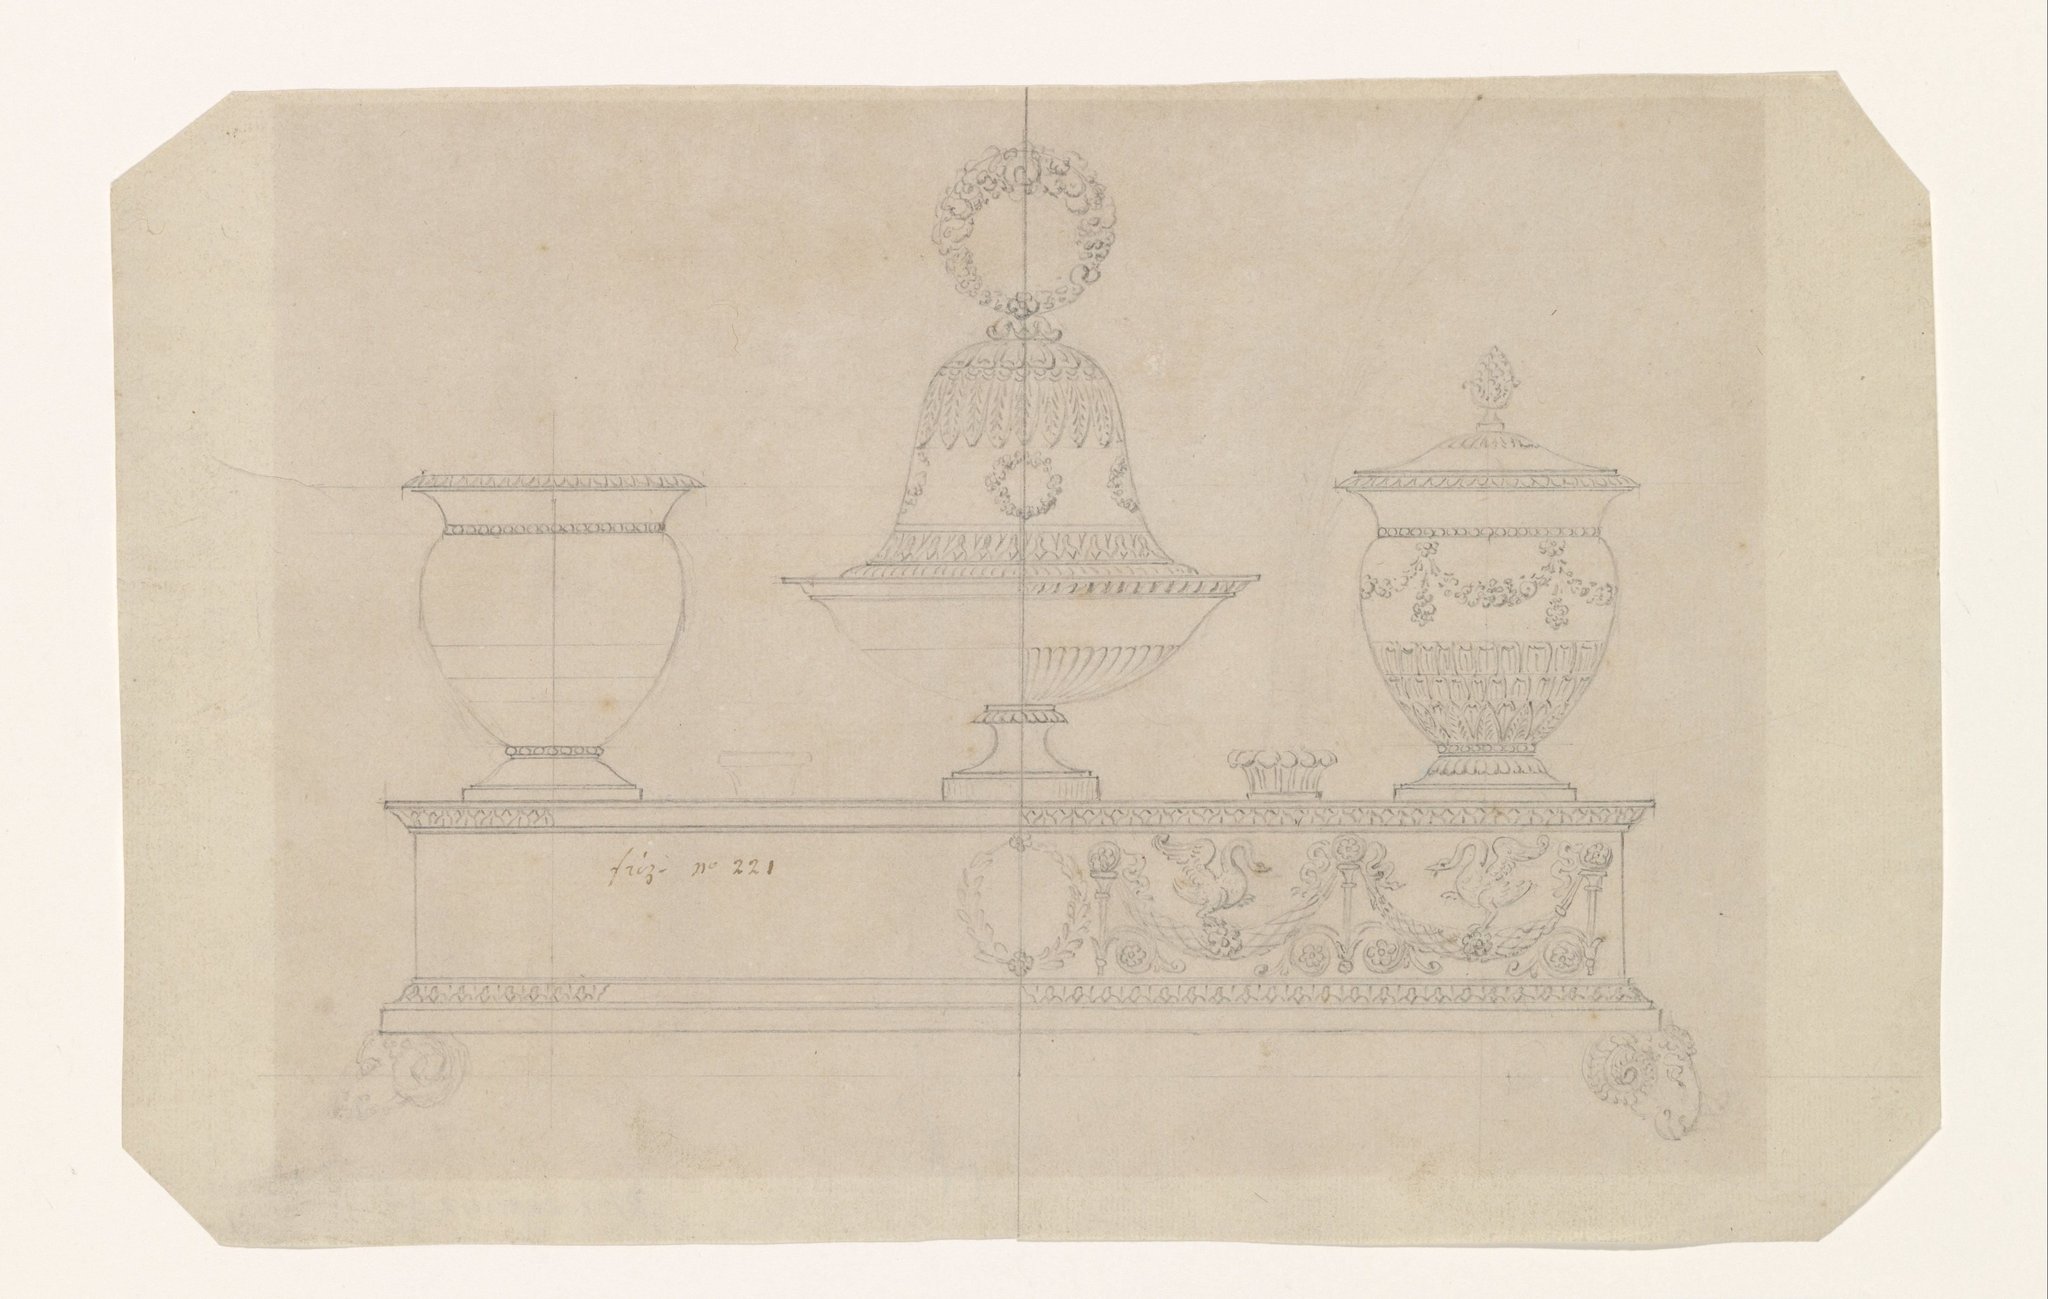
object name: drawing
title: Ontwerp voor een inkstel met een zandpot, een bel op een komvormige voet, pennehouders en een inktpot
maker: Anonymous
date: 1800-1820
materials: graphite, paper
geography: paris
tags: ink-well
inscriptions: inscription: ‘frize no 221’, watermark: ‘Palmet of verenbos met zes veren.’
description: Alleen de rechterhelft is geheel uitgewerkt.